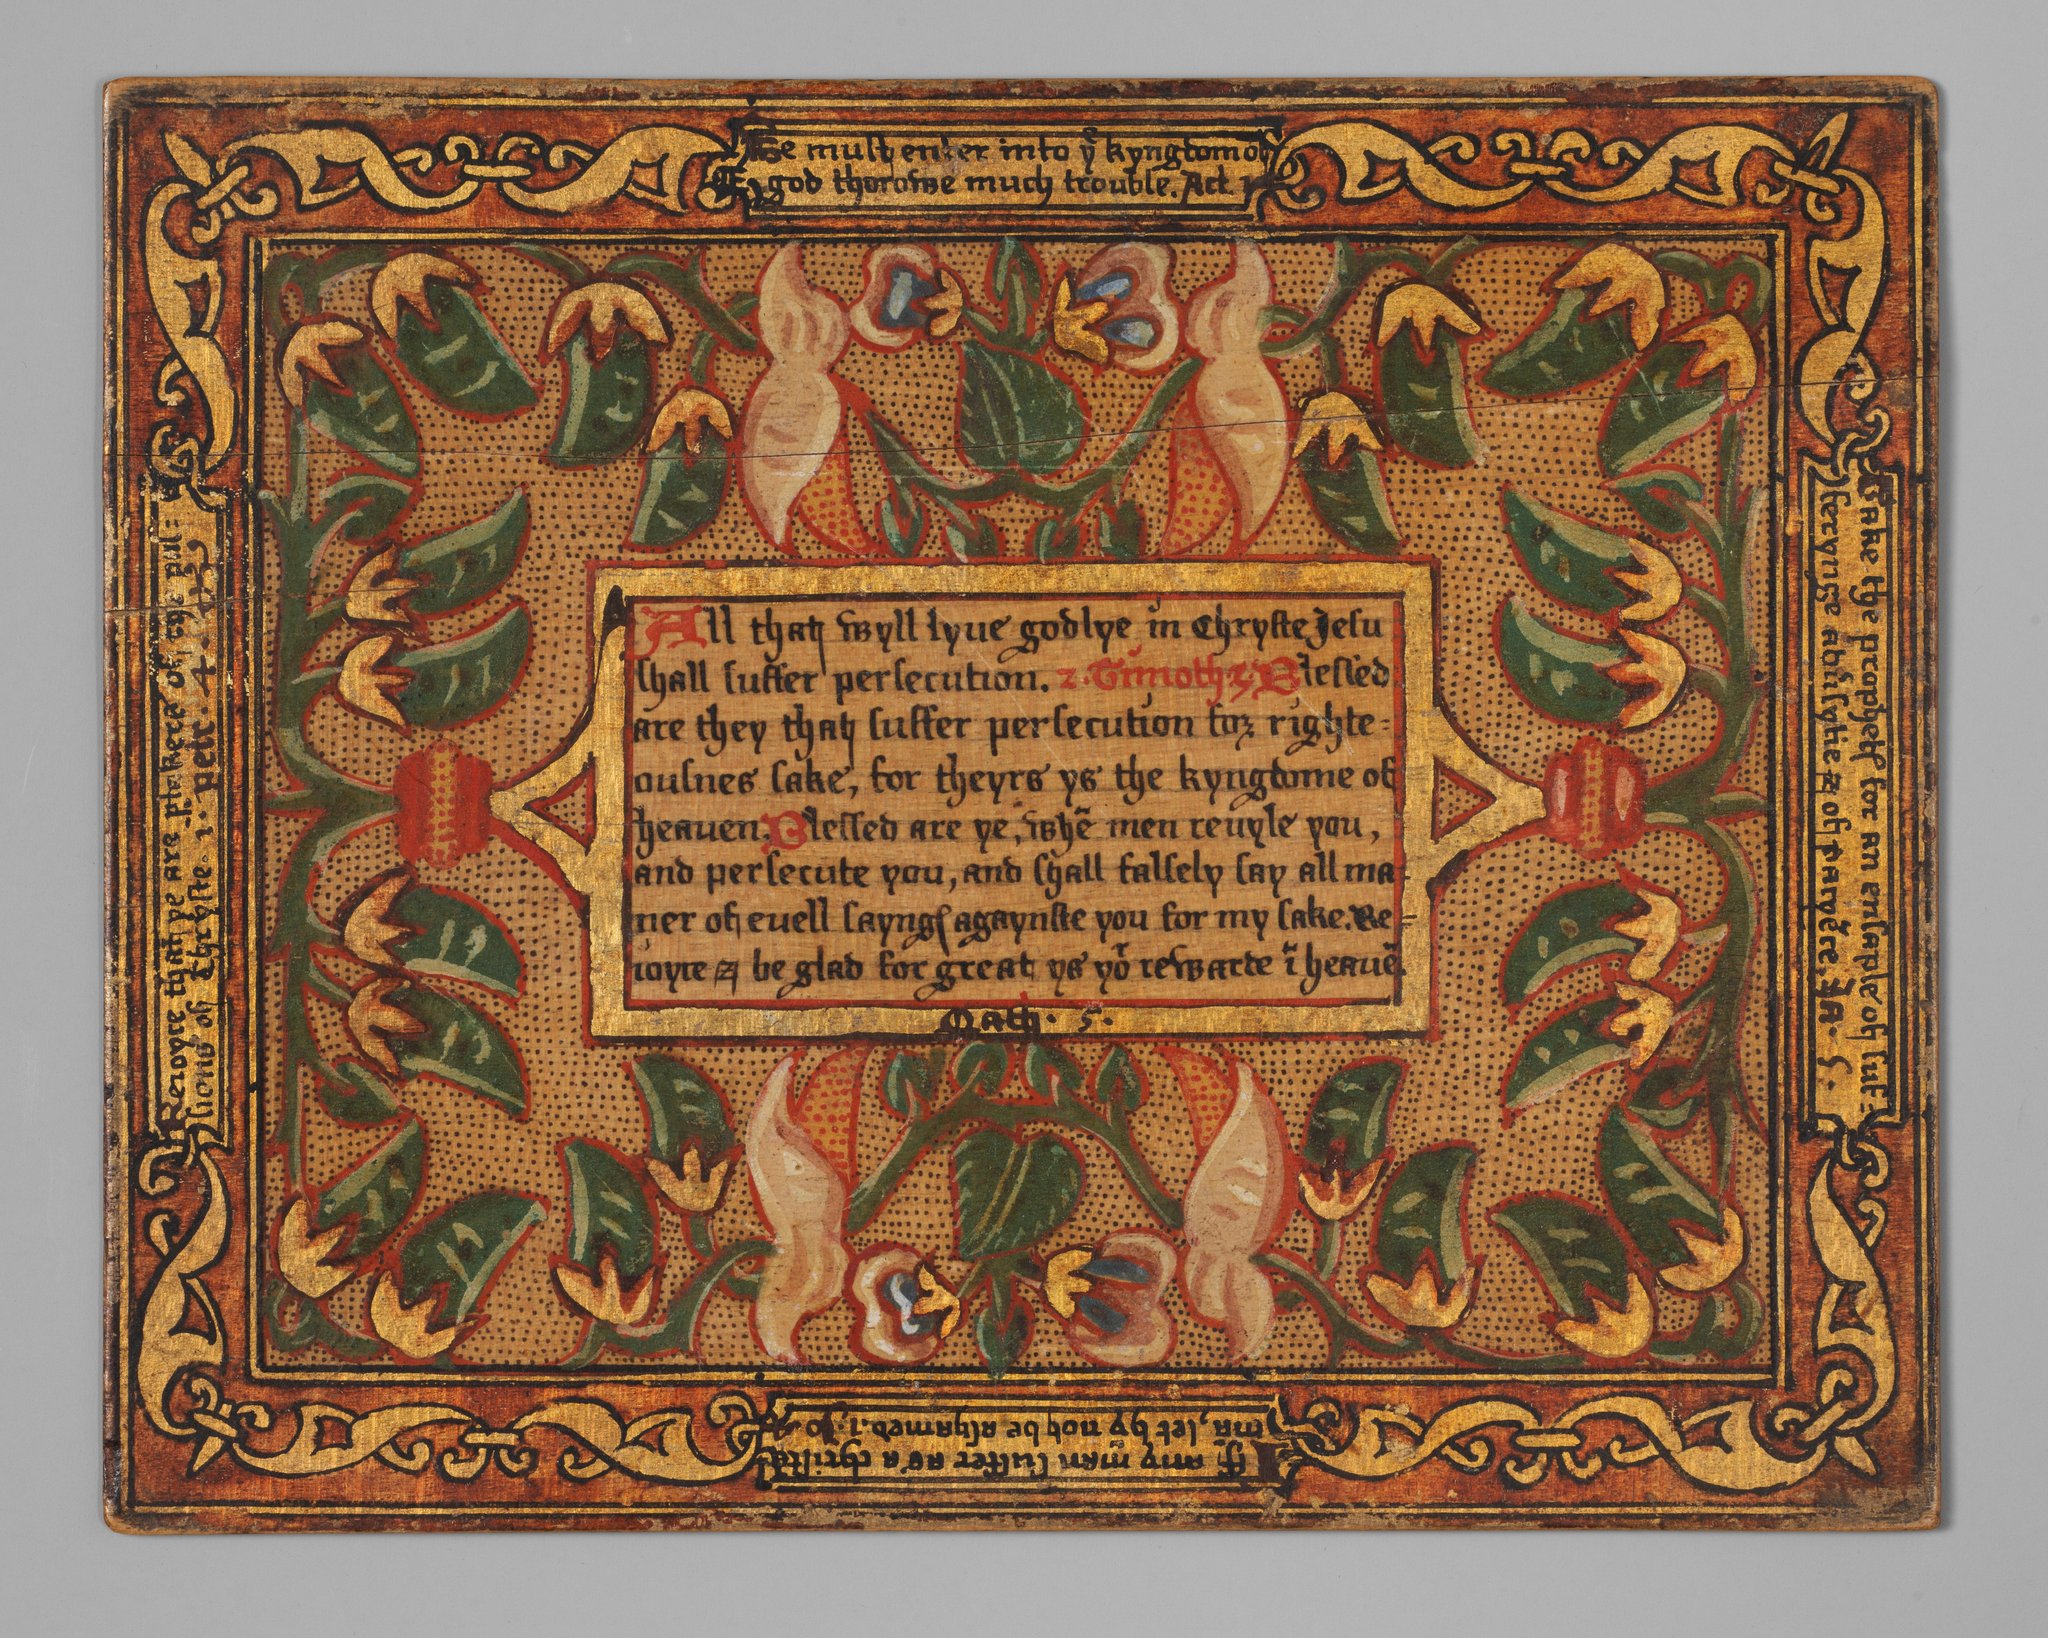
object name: trencher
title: Trencher with quotation from The Governance of Virtue (1566) (one of a set)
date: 1601-1633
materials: gilt, wood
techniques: painting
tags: flowers